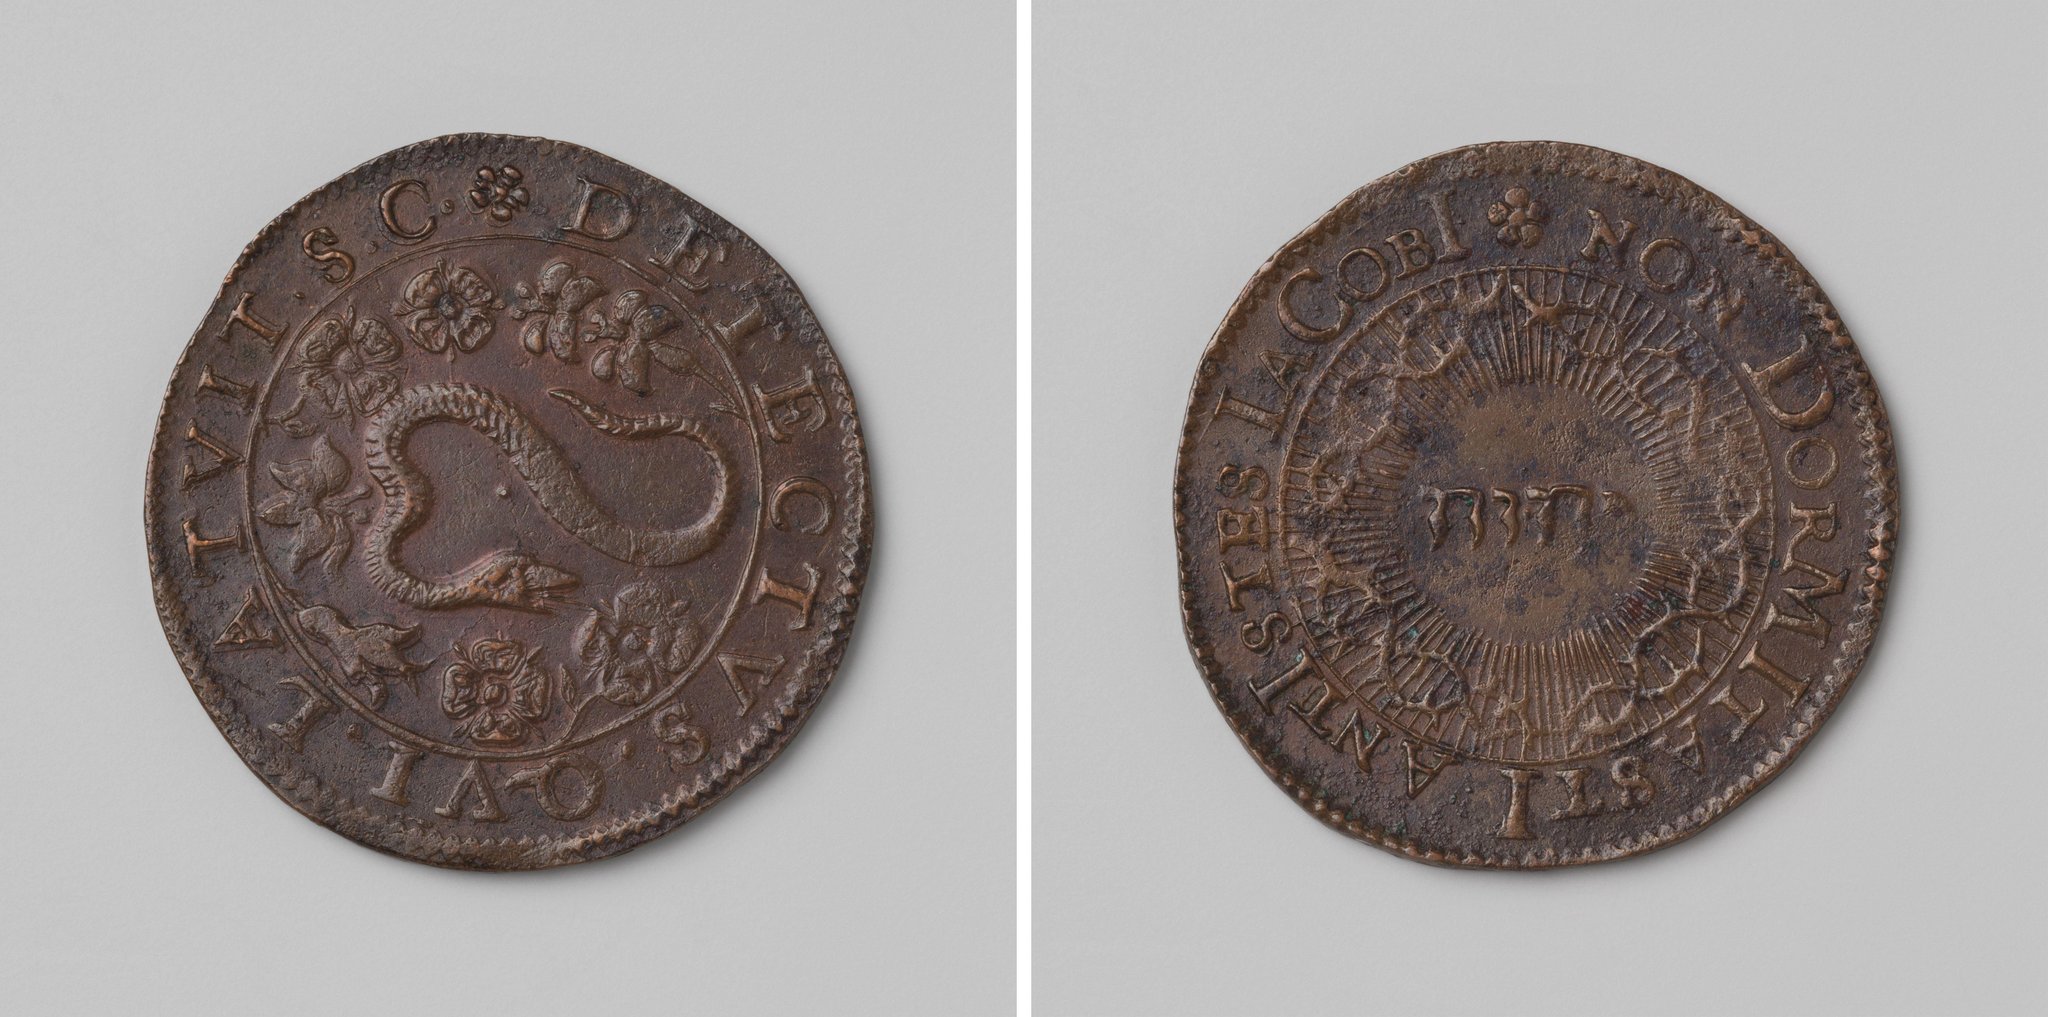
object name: jeton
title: Ontmaskering van het Gunpowder Plot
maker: Anonymous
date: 1605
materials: copper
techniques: striking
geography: dordrecht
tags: london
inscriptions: circumscription: ‘Non DorMItastI AntIstes IaCobI’, circumscription: ‘Detectus, qui latuit / SC’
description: Koperen penning. Voorzijde: kronkelende slang temidden van rozen en lelies binnen omschrift. Keerzijde: naam Jehova in Hebreeuws schrift binnen stralende doornenkroon en omschrift